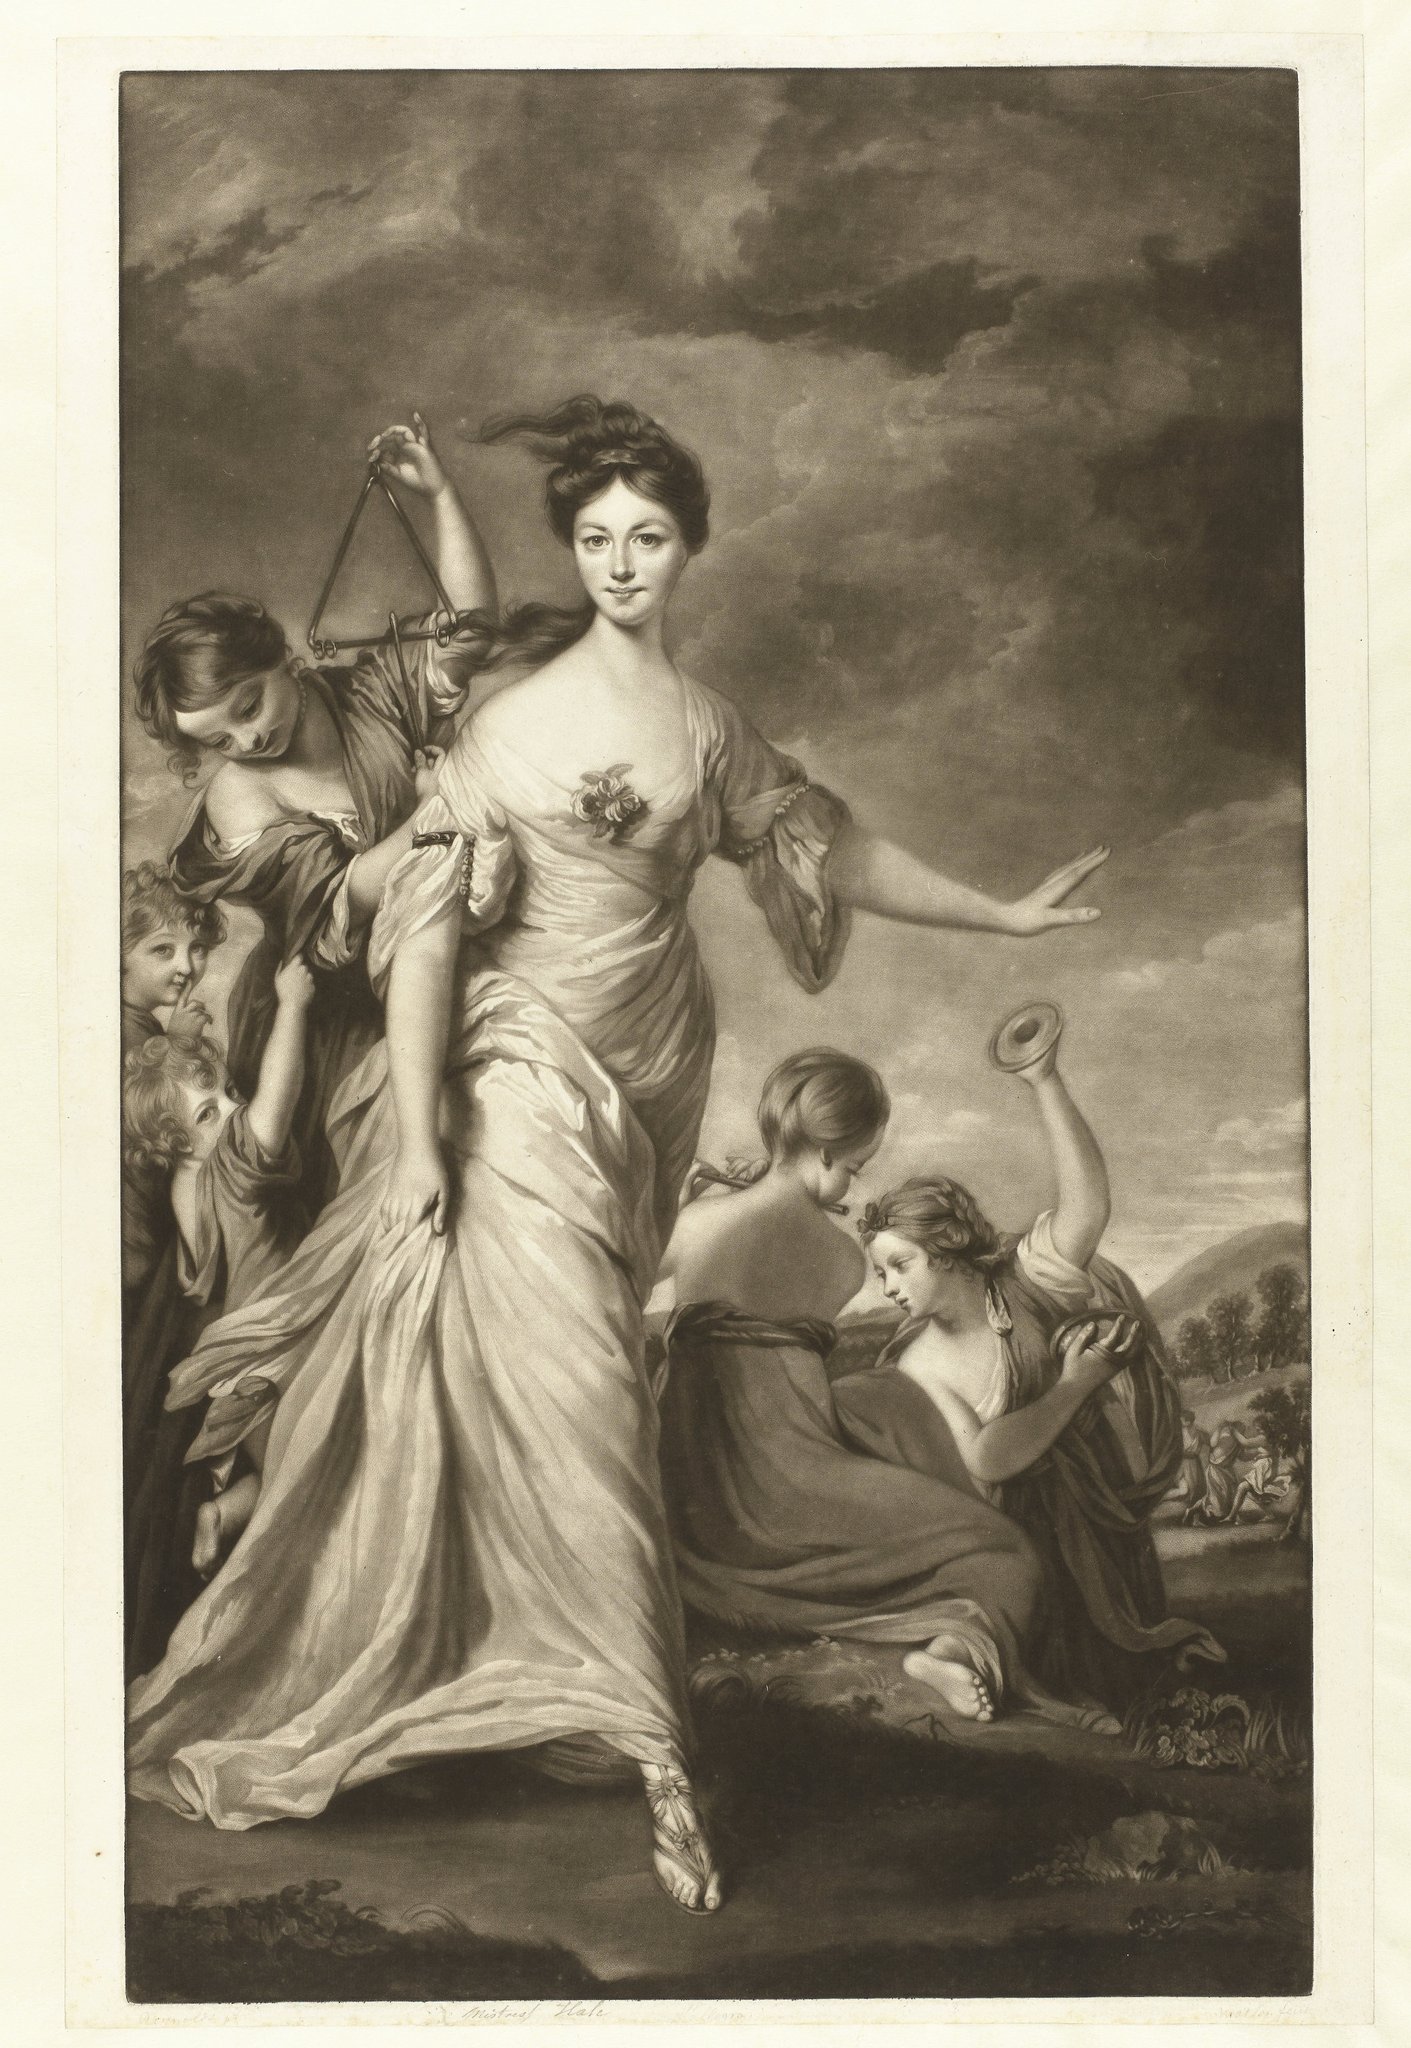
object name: print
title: Portret van Mary Hale als Euphrosyne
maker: james watson (prentmaker)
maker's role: print maker, publisher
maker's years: 1740-1790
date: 1766-1790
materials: paper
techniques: mezzotint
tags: historical persons - bb - woman, flute, aulos, tibia - cc - out of doors, other percussion instruments (with name), female literary characters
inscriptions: collector's mark: Lugt 240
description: Hale als Euphrosyne uit John Miltons L'Allegro.